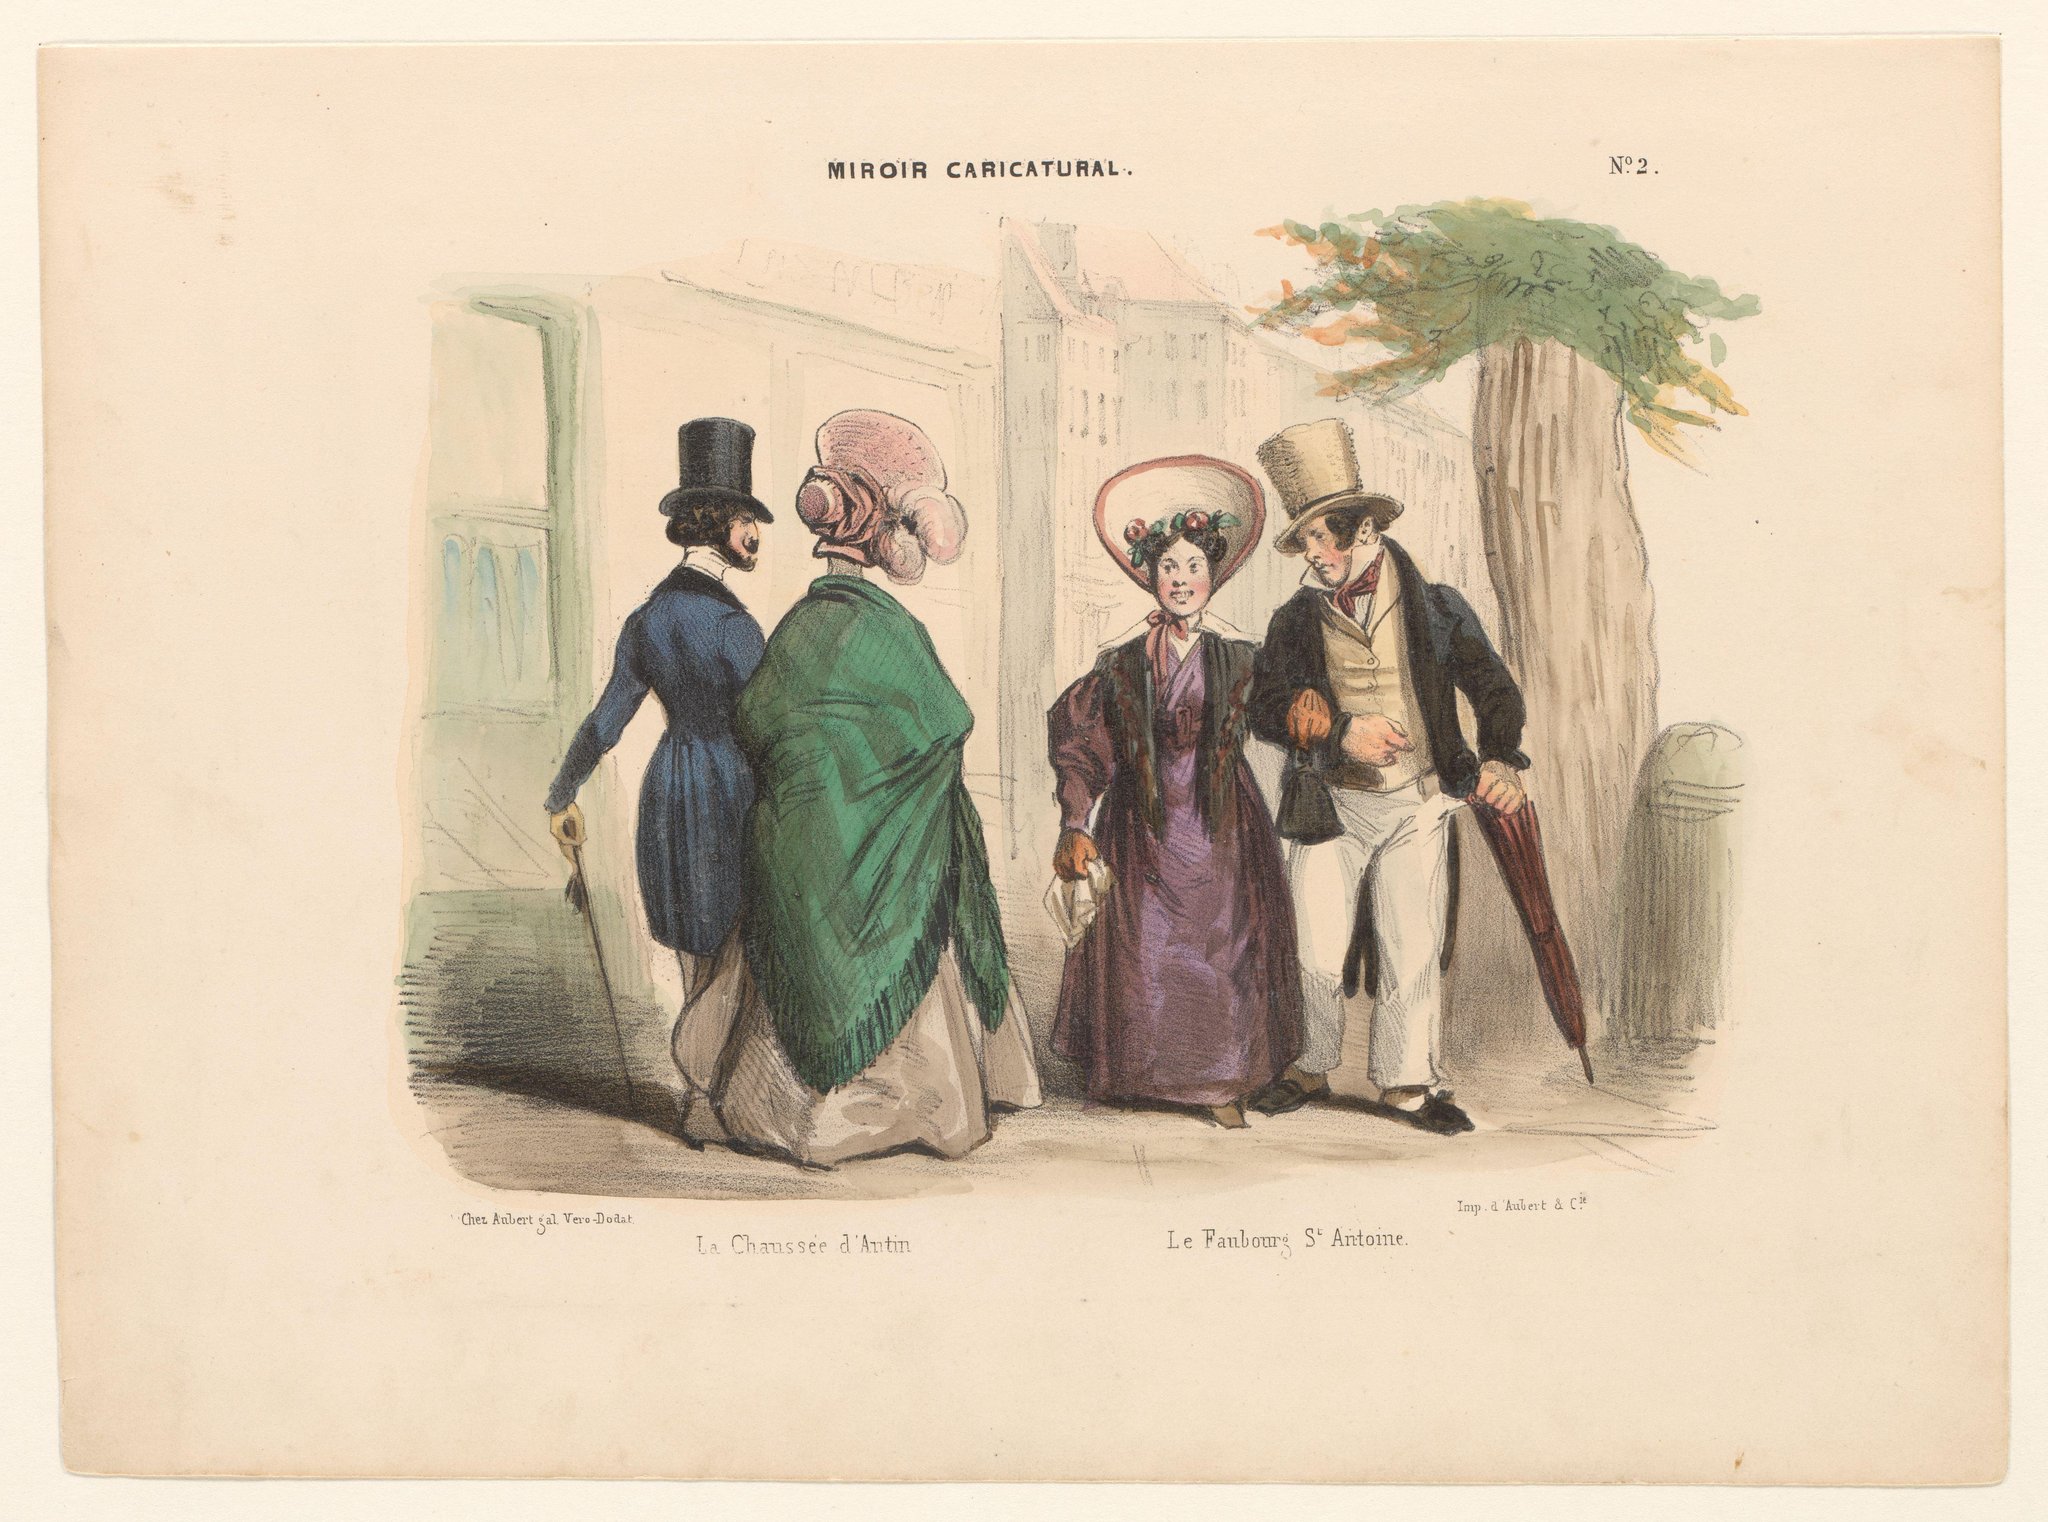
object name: cartoon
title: La Chaussée d'Antin / Le Faubourg St. Antoine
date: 1820-1840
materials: paper, watercolor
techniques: hand coloring, lithograph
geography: france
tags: fashion, paris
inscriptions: collector's mark: Lugt 2228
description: Twee modieus geklede paren komen elkaar in Parijs tegemoet. Het linker paar, op de rug gezien komt uit La Chaussée d'Antin, het rechter paar vertegenwoordigt Le Faubourg St. Antoine